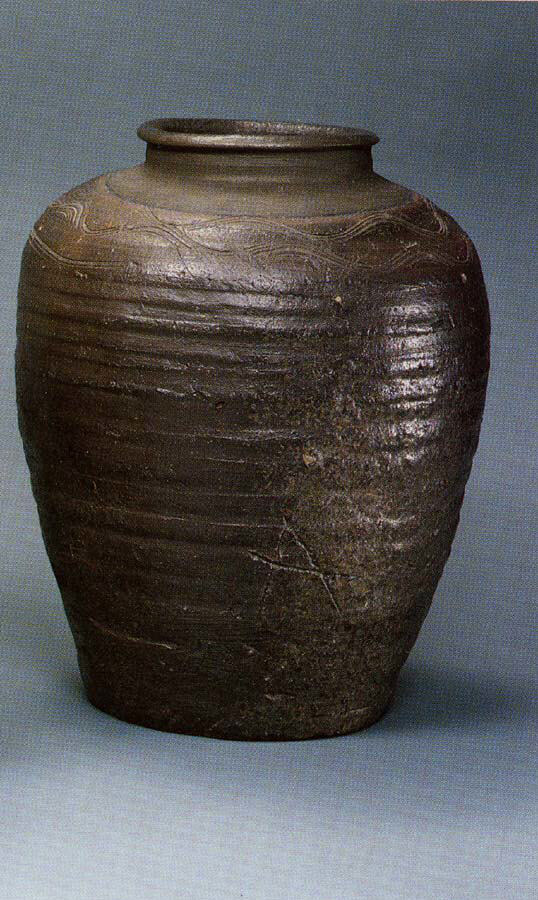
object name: storage jar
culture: japanese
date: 1500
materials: wood, glaze, stoneware